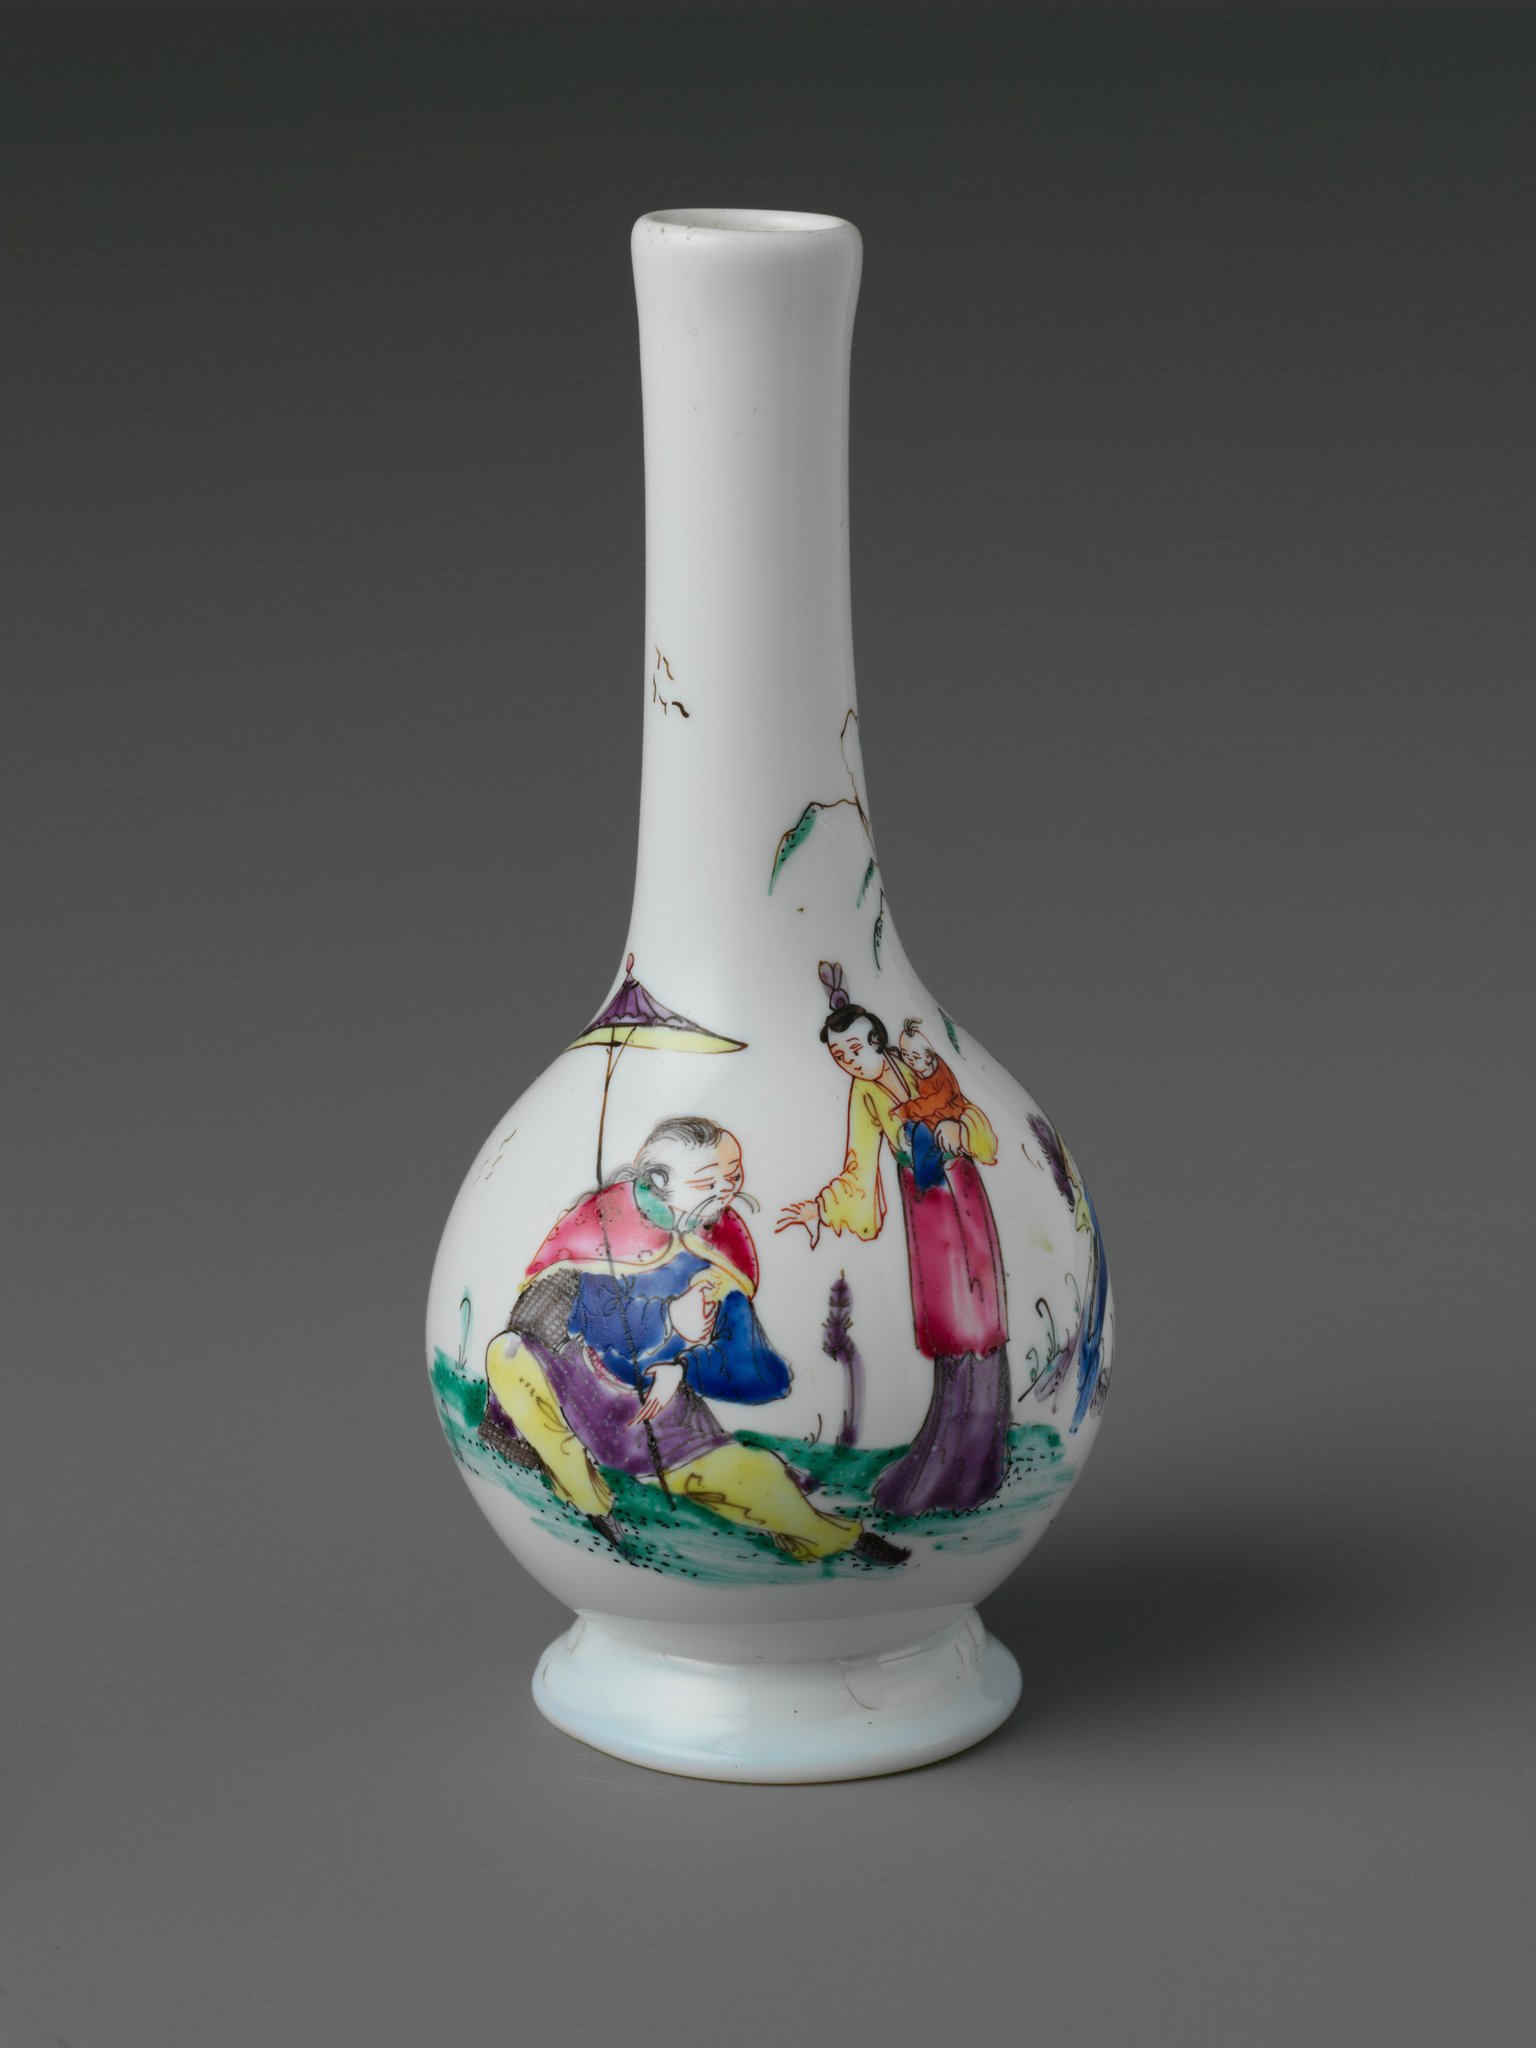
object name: bottle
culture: british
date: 1760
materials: enamel, glass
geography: england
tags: children,men,women